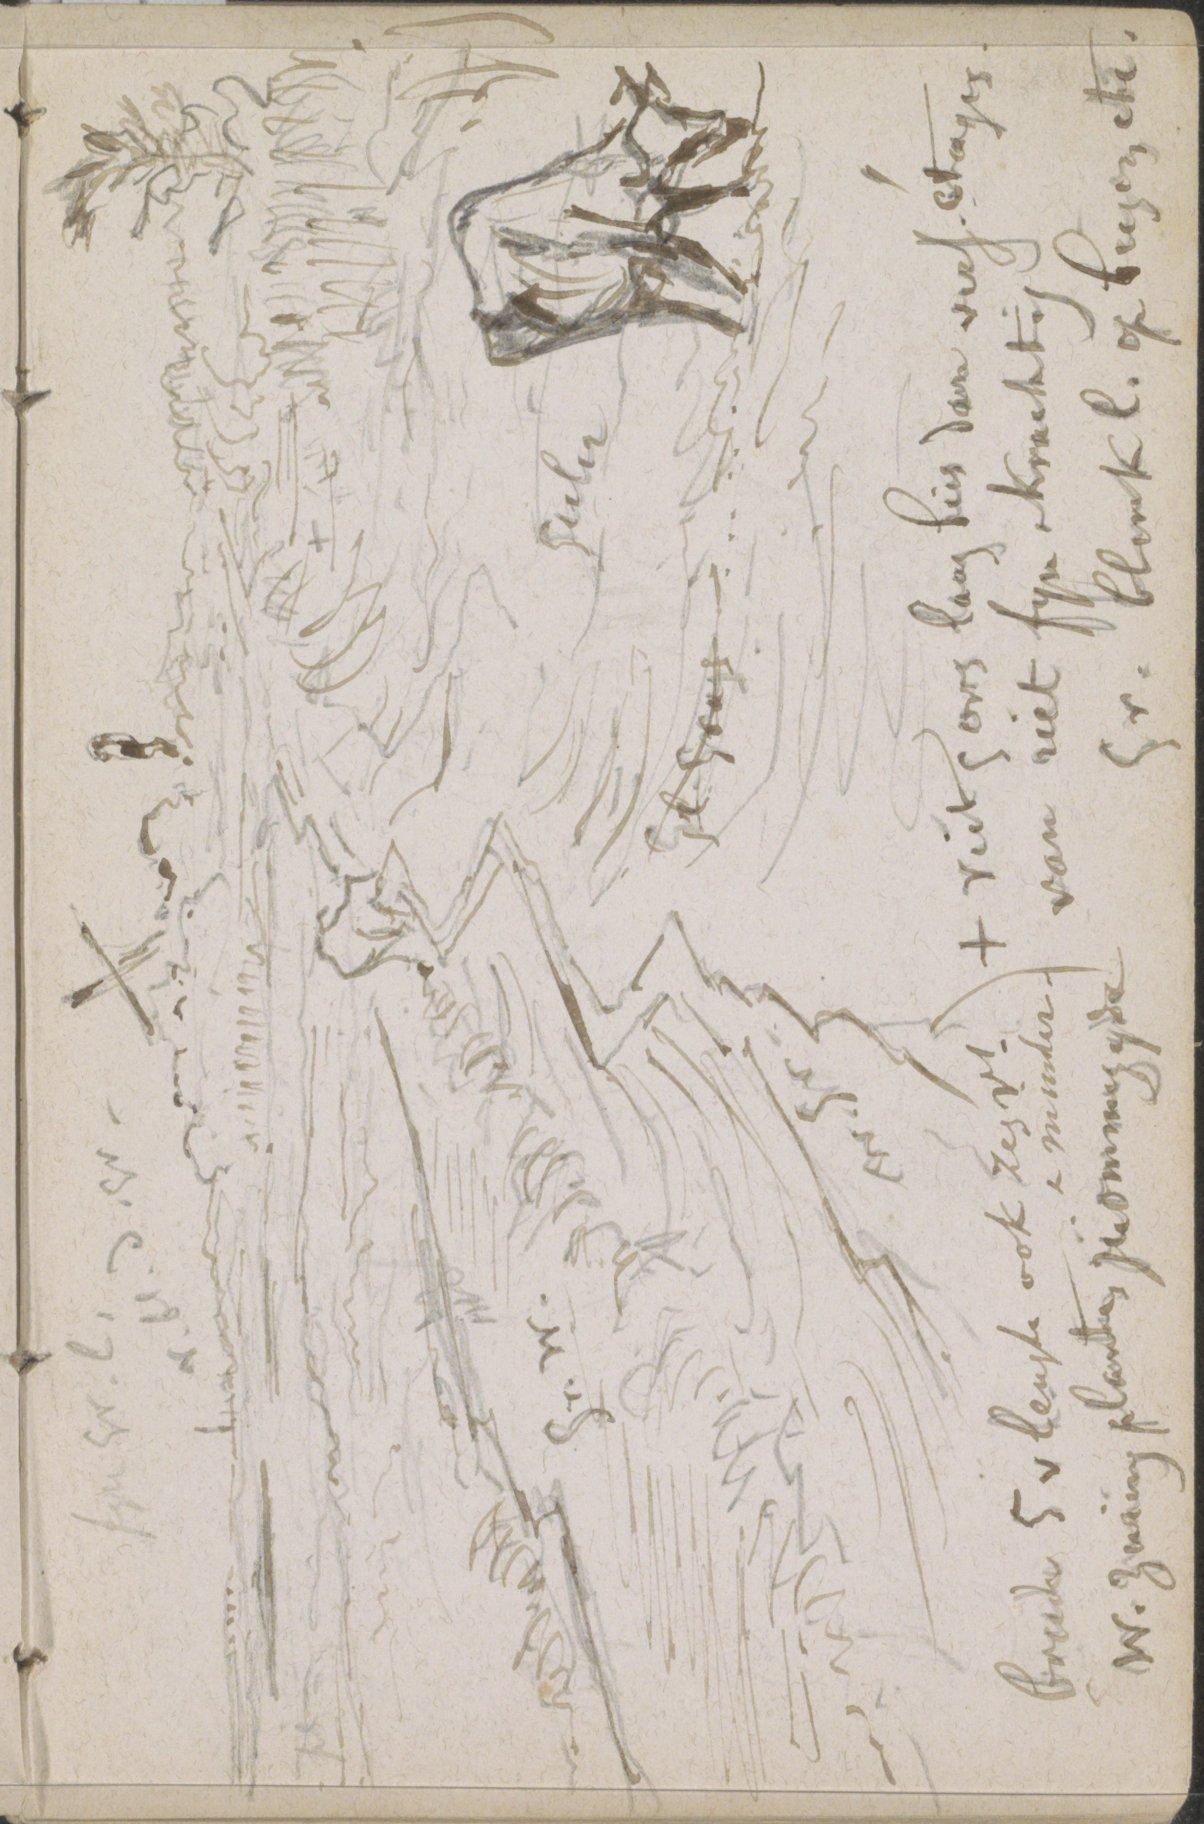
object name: sketchbook leaf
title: Weidelandschap met een molen en een grazende koe bij een sloot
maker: johannes tavenraat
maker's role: draughtsman, painter, print maker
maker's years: 1809-1881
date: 1862-1864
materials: ink, paper, pencil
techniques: pen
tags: cow, meadow, pasture, windmill in landscape, small canal, ditch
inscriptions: kleurnotitie, handgeschreven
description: Blad 8 recto uit een schetsboek met 65 bladen.